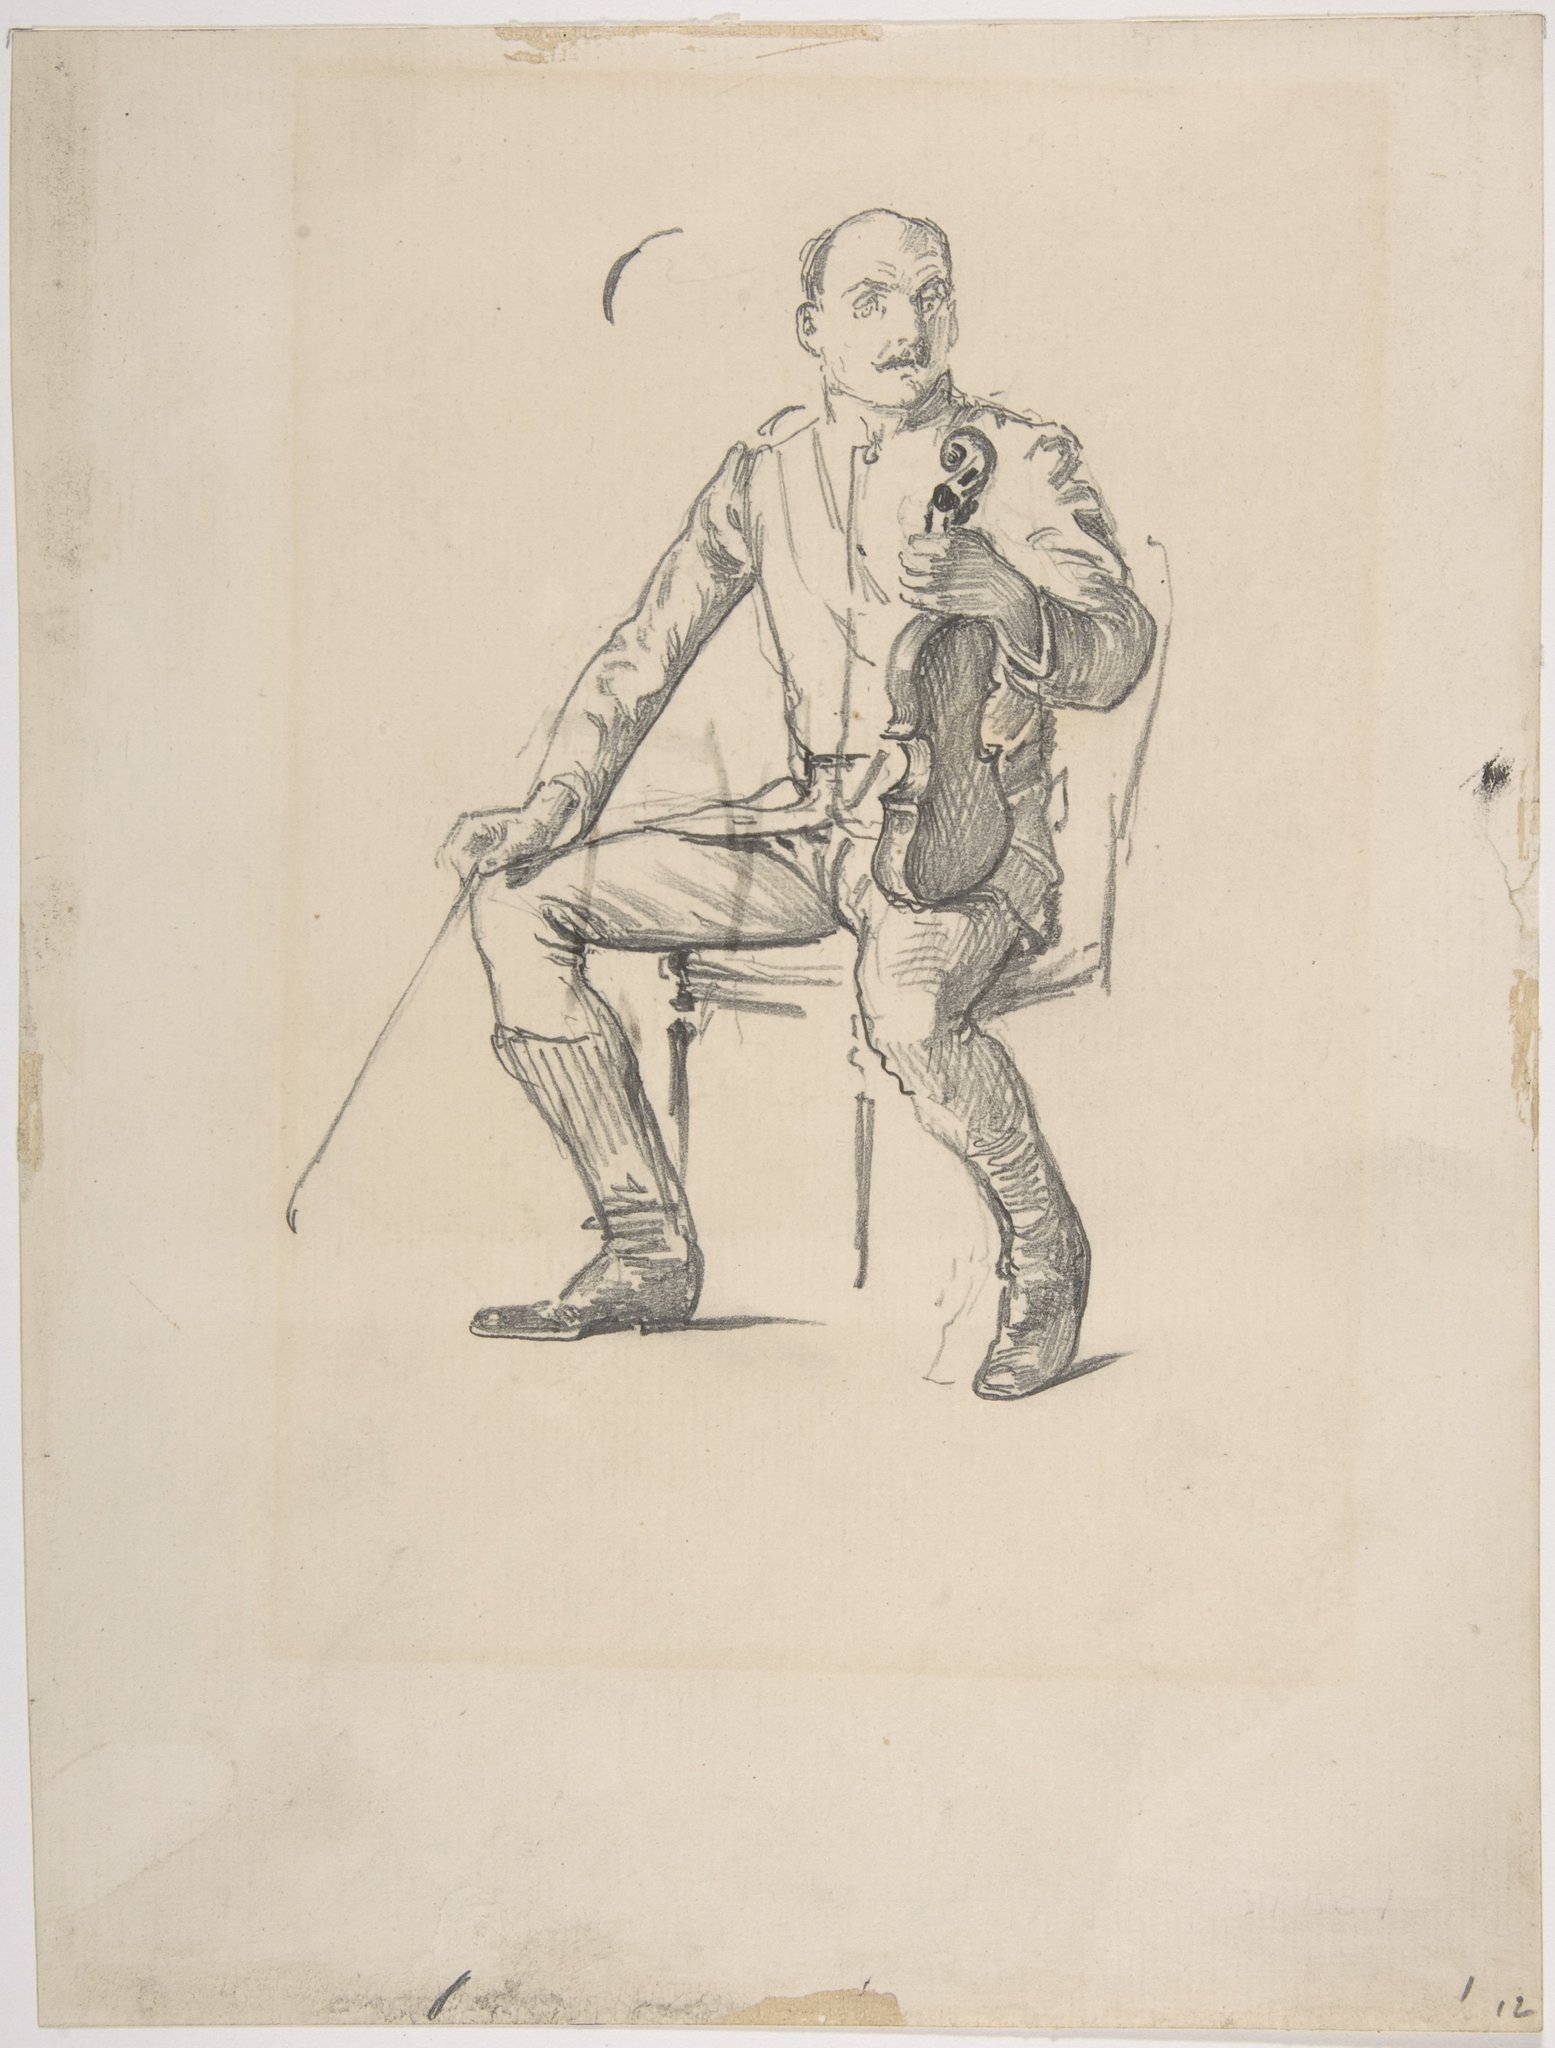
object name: drawing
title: Violinist: study from life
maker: george du maurier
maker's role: artist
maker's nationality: british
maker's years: 1834-1896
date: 1851-1900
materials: graphite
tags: men,violins